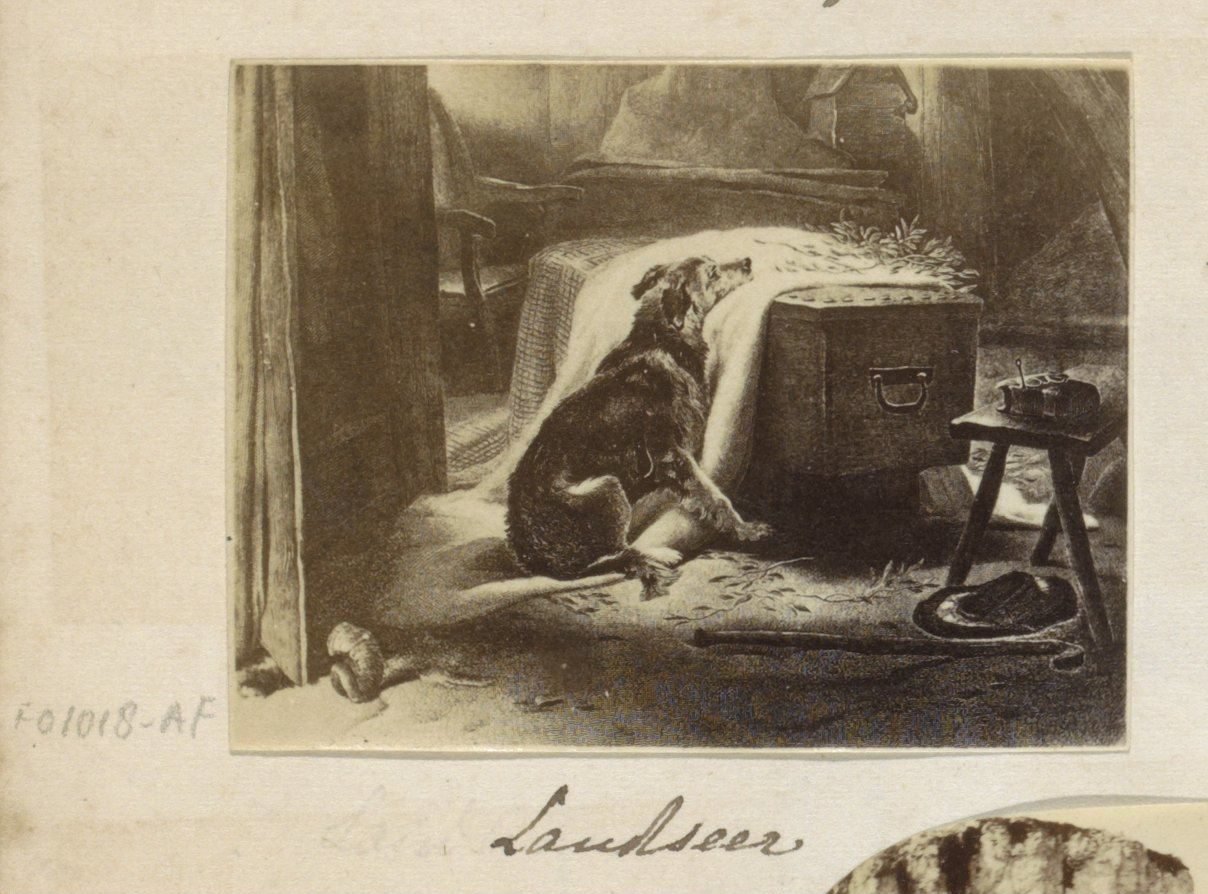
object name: reproduction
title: Fotoreproductie van een schilderij van Edwin Henry Landseer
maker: Anonymous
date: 1860-1870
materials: paper, photographic support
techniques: albumen print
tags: dog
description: Onderdeel van Engels familiealbum met foto's van personen, reizen, cricket en kunstwerken.